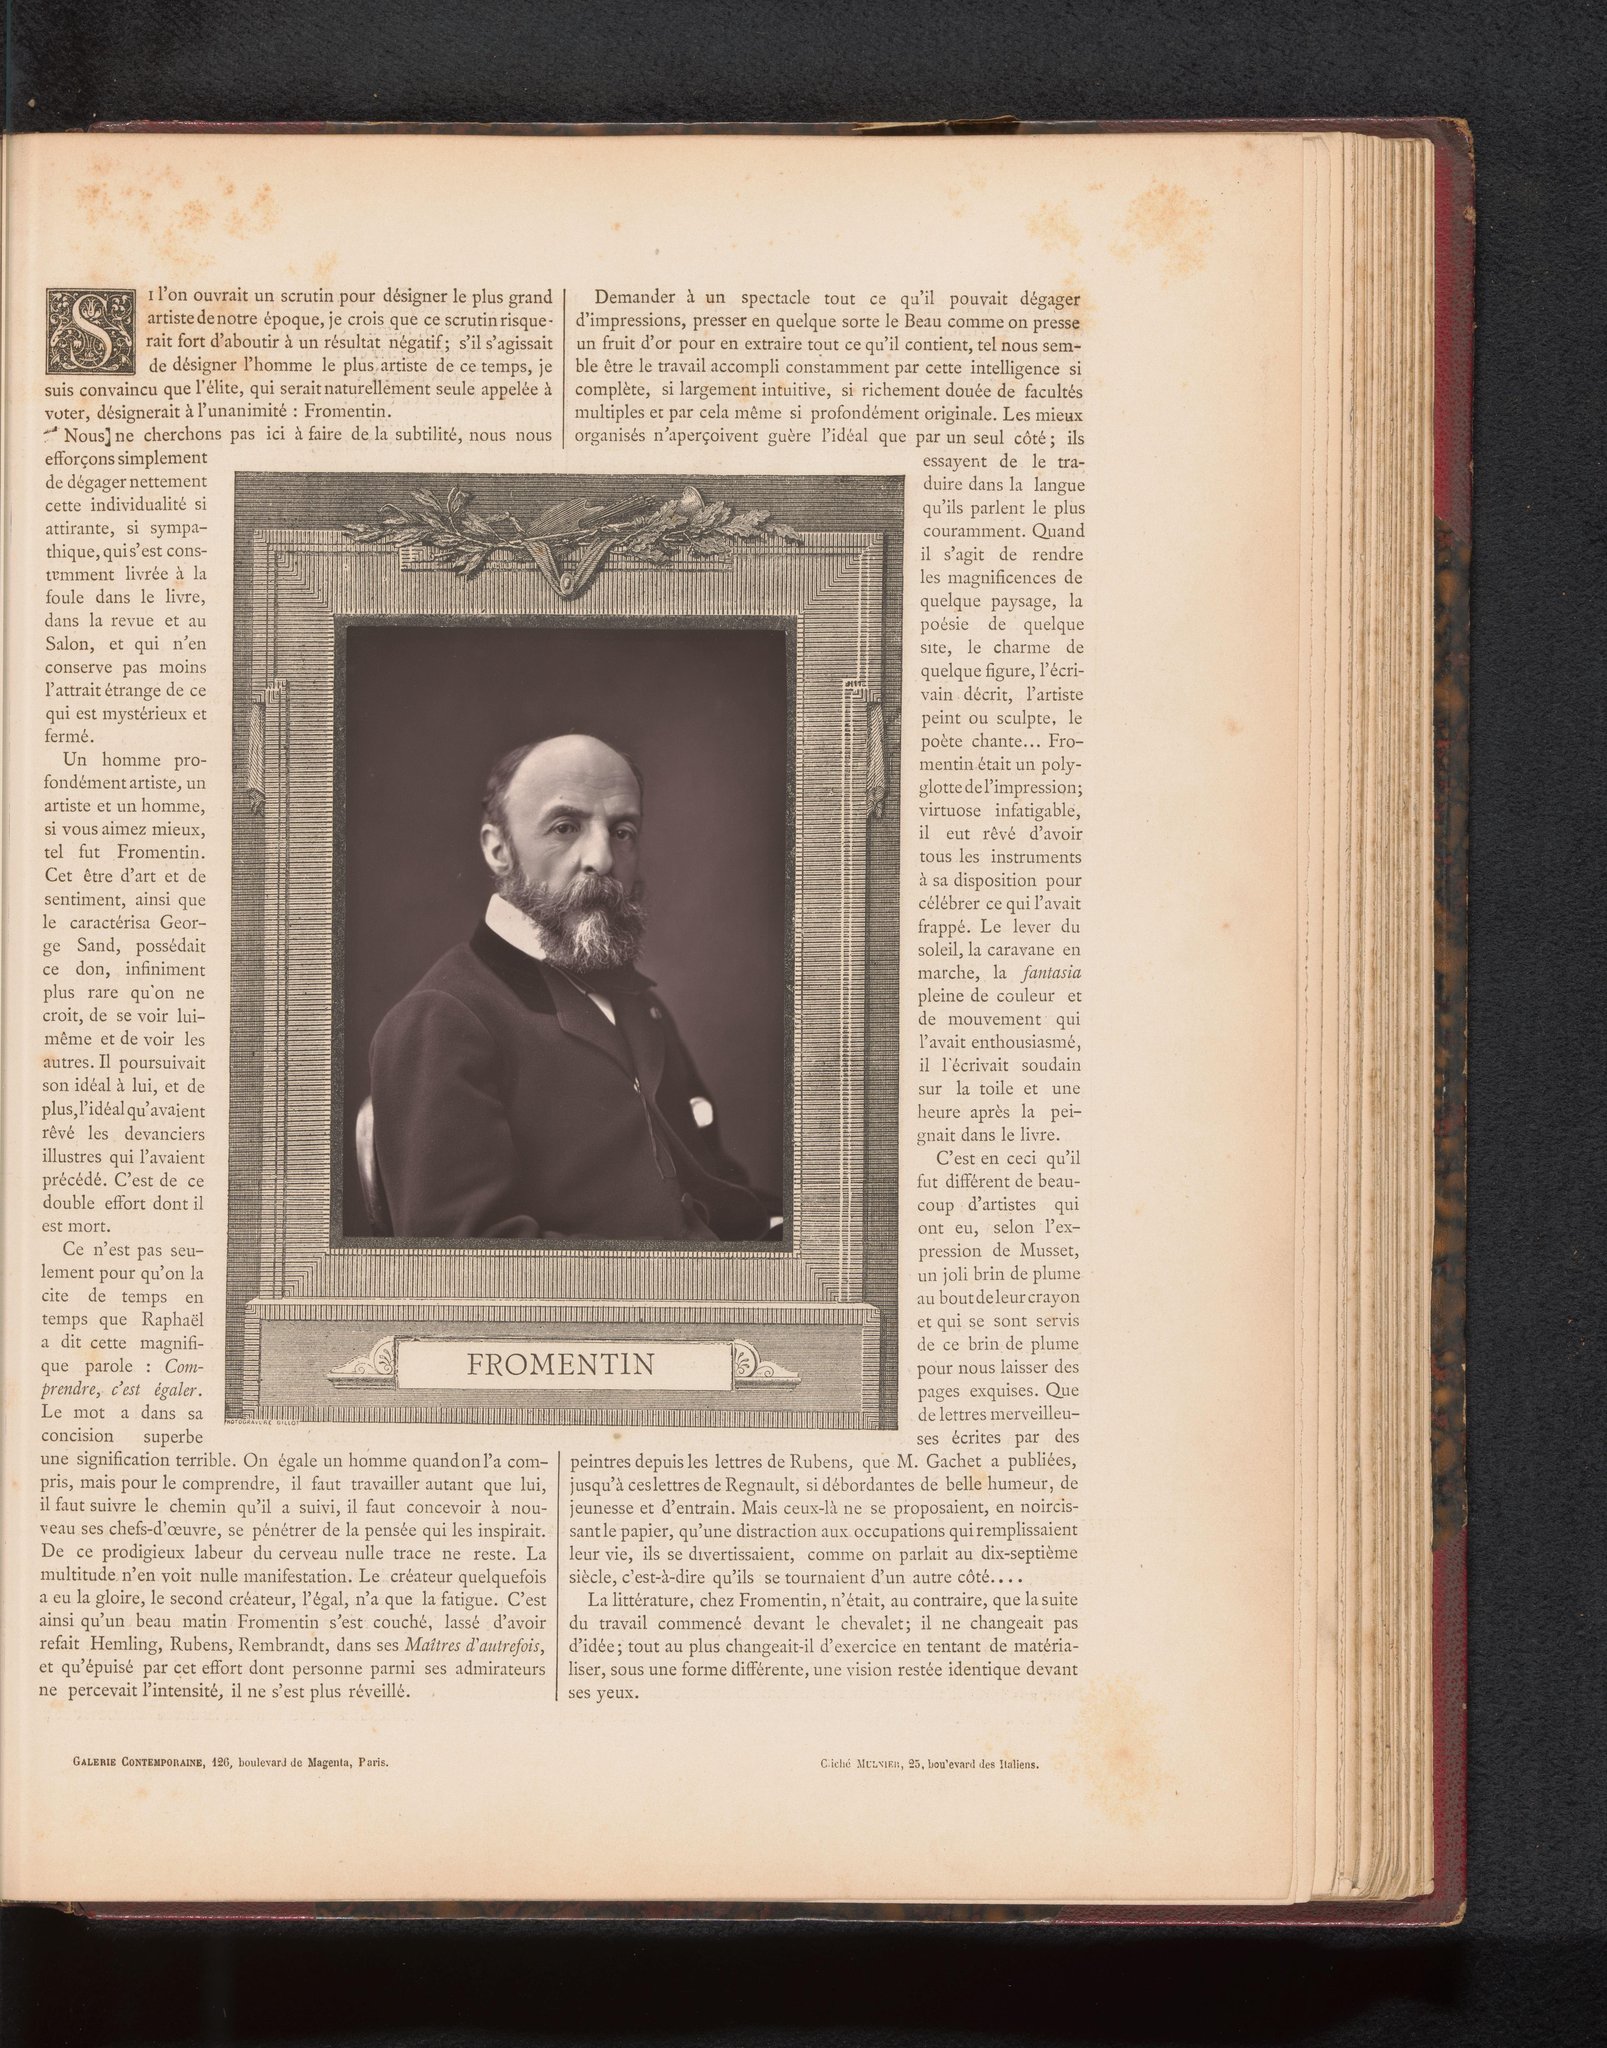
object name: page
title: Portret van Eugène Fromentin-Dupeux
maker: ferdinand mulnier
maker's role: painter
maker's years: 1817-1891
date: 1871-1876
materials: paper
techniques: woodburytype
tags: eugène fromentin-dupeux, adult man, historical persons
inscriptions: inscription: ‘Galerie Contemporaine, 126, boulevard de Magenta, Paris.’